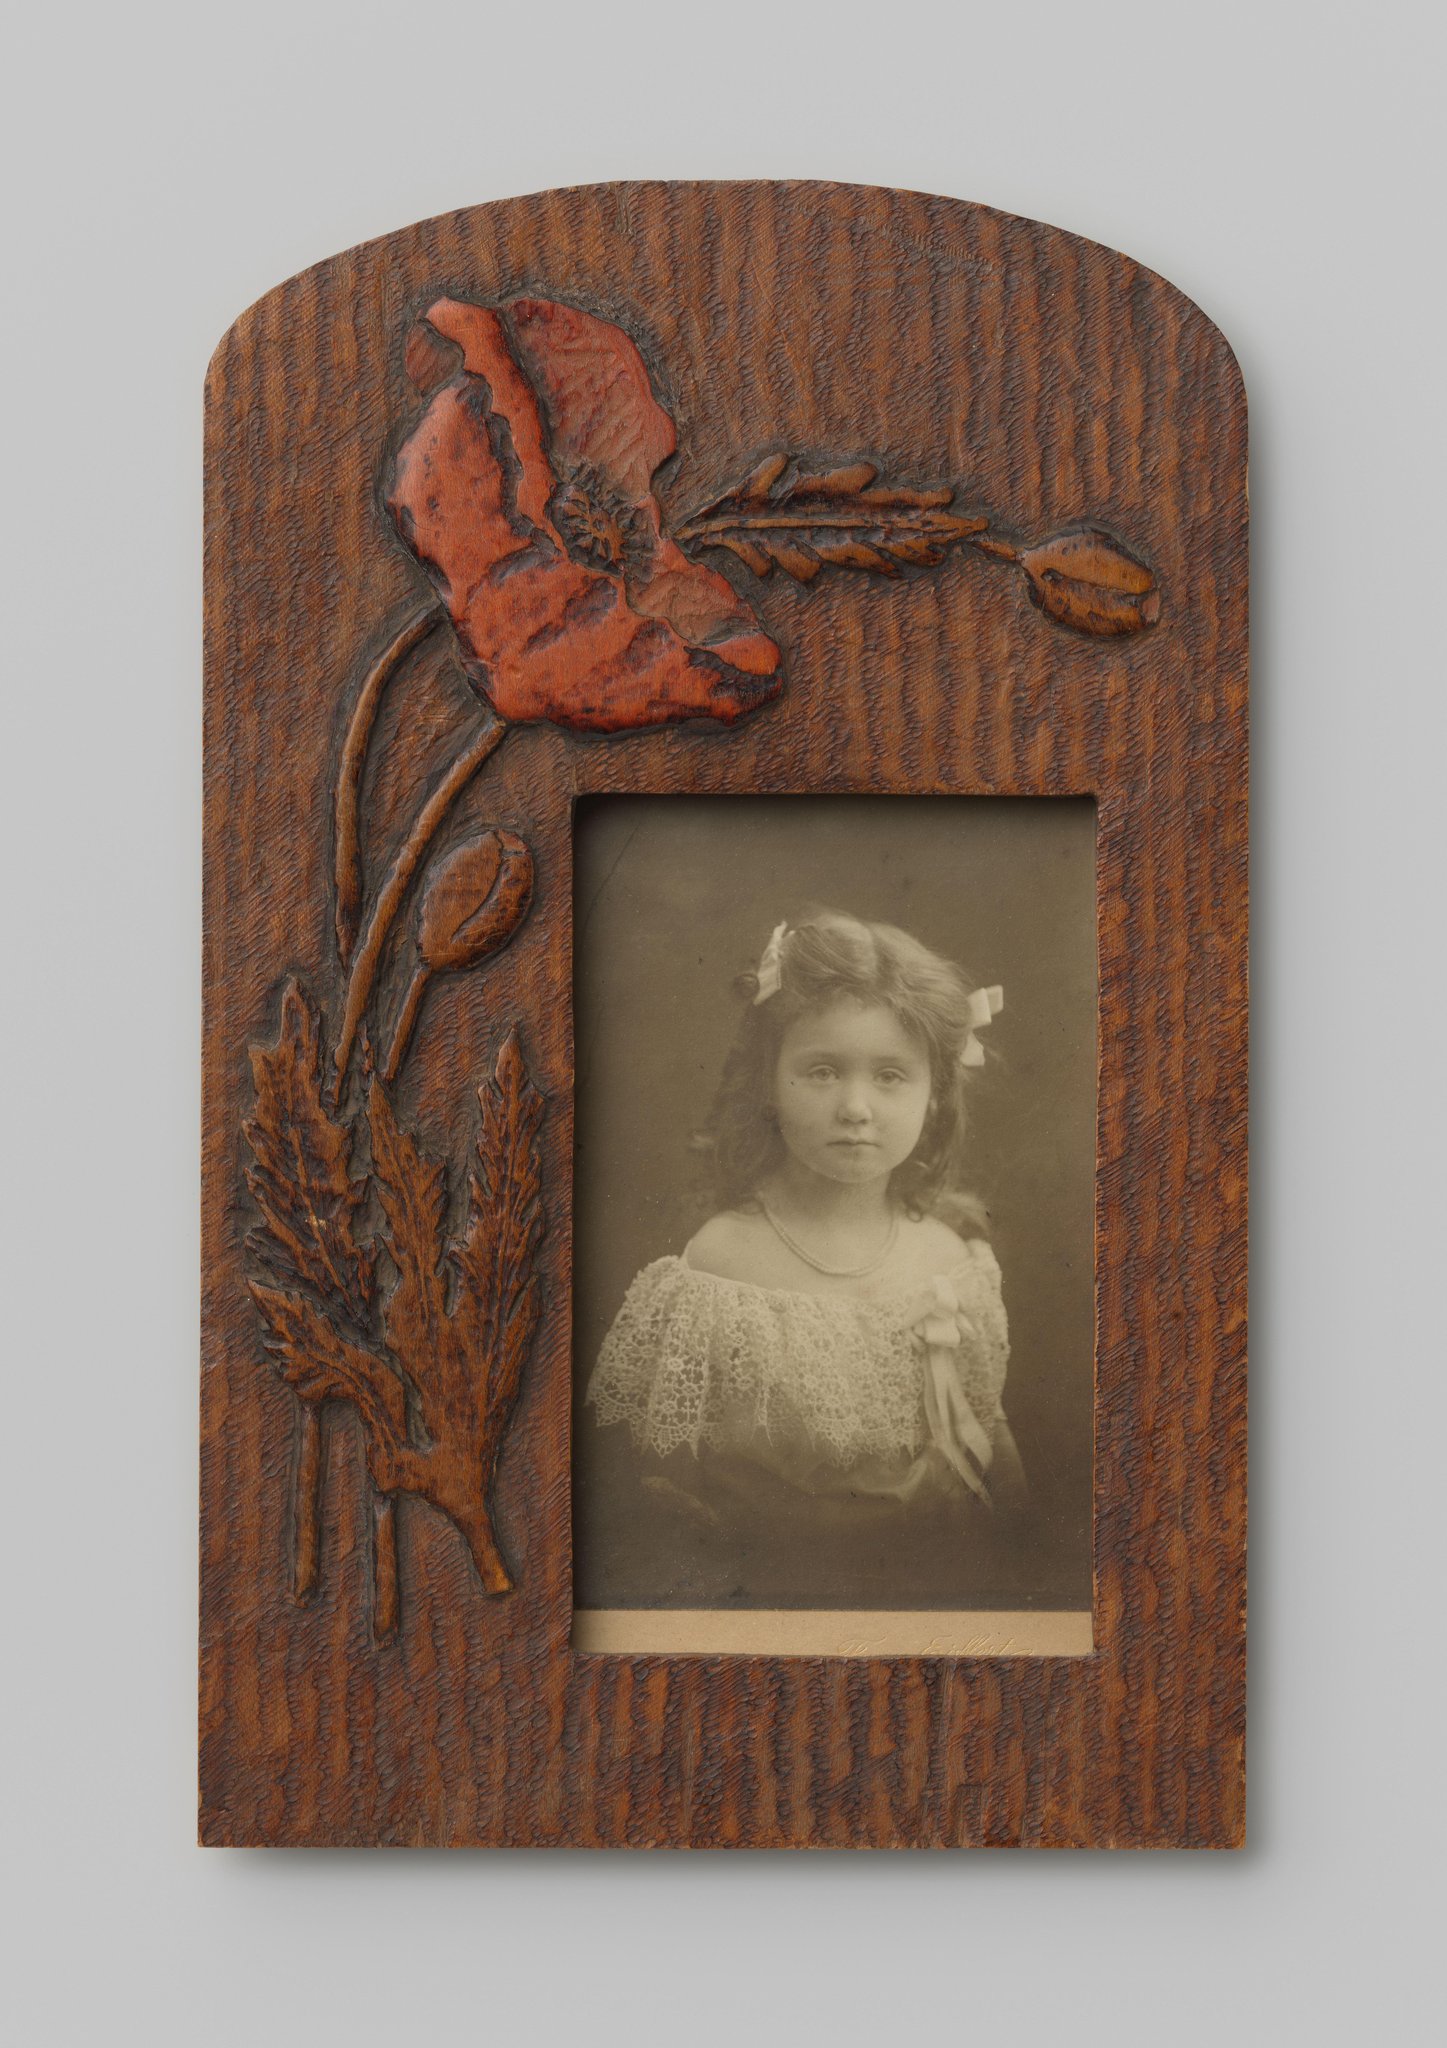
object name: cabinet photograph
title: Portret van een onbekend meisje met ketting en strikken in het haar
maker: franz eiffert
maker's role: fotograaf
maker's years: 1866-1929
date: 1876-1907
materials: paper, cardboard, glass, metal, wood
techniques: gelatin silver print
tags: girl (child between toddler and youth), anonymous historical person portrayed, necklace